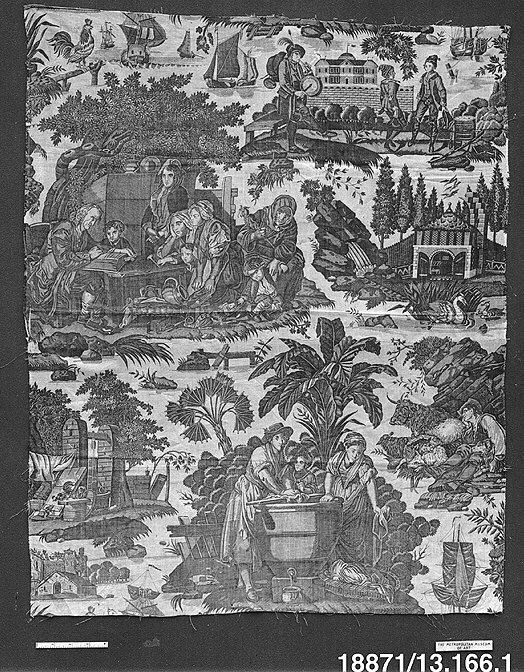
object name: furnishing textile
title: "La Danse Savoyarde"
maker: lecler, père et fils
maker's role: manufactory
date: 1790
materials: cotton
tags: men,women,roosters,trees,boats